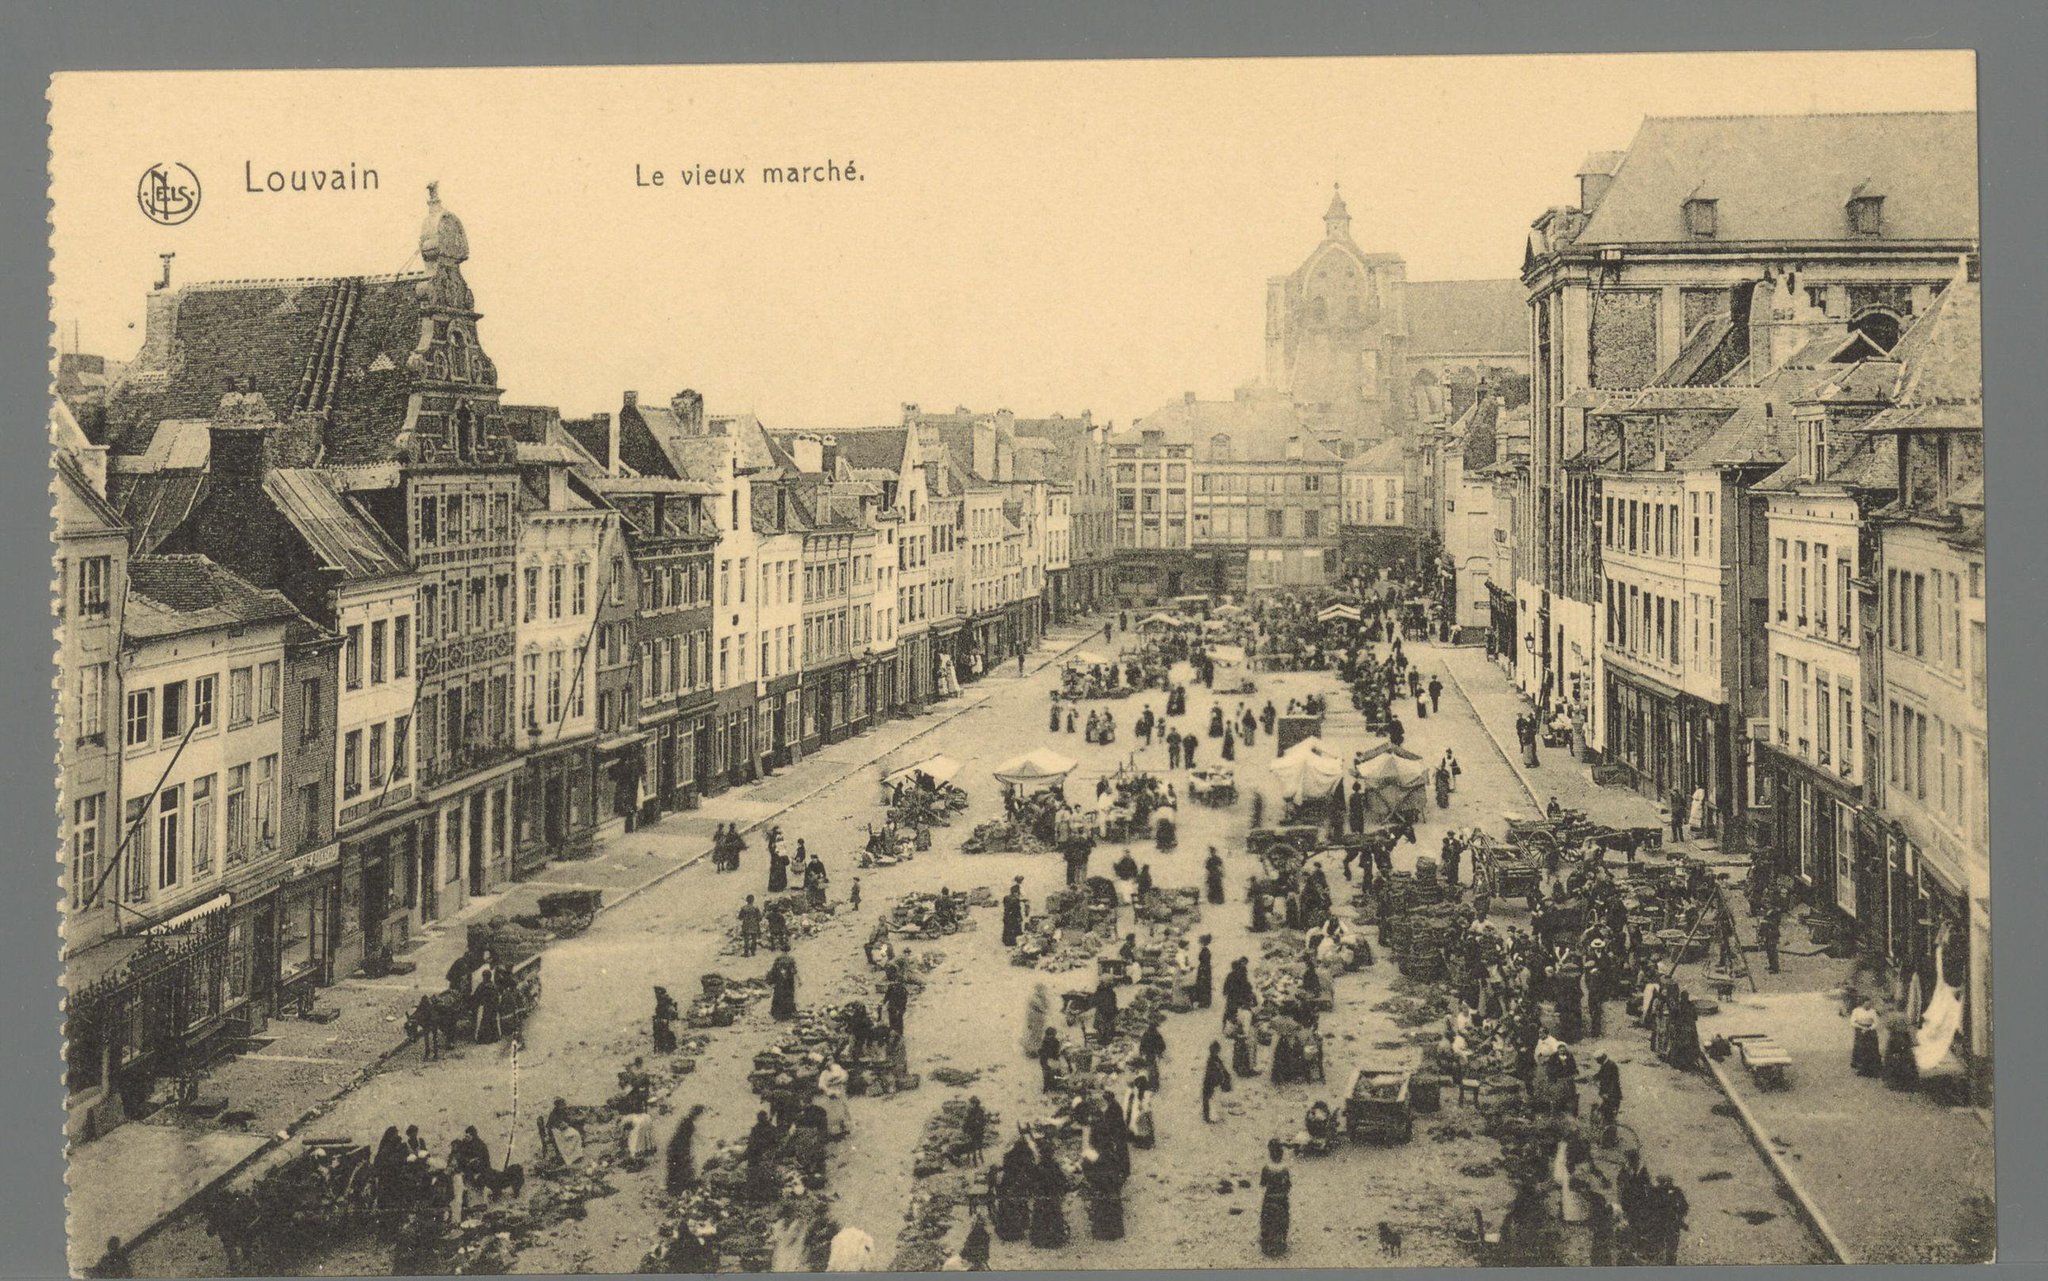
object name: ansichtkaart, prentbriefkaart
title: Louvain. Le vieux marché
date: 1913-1914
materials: cardboard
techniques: photograph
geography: brussels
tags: square, place, circus, etc., market, prospect of city, town panorama, silhouette of city (+ city(-scape) with figures, staffage), louvain